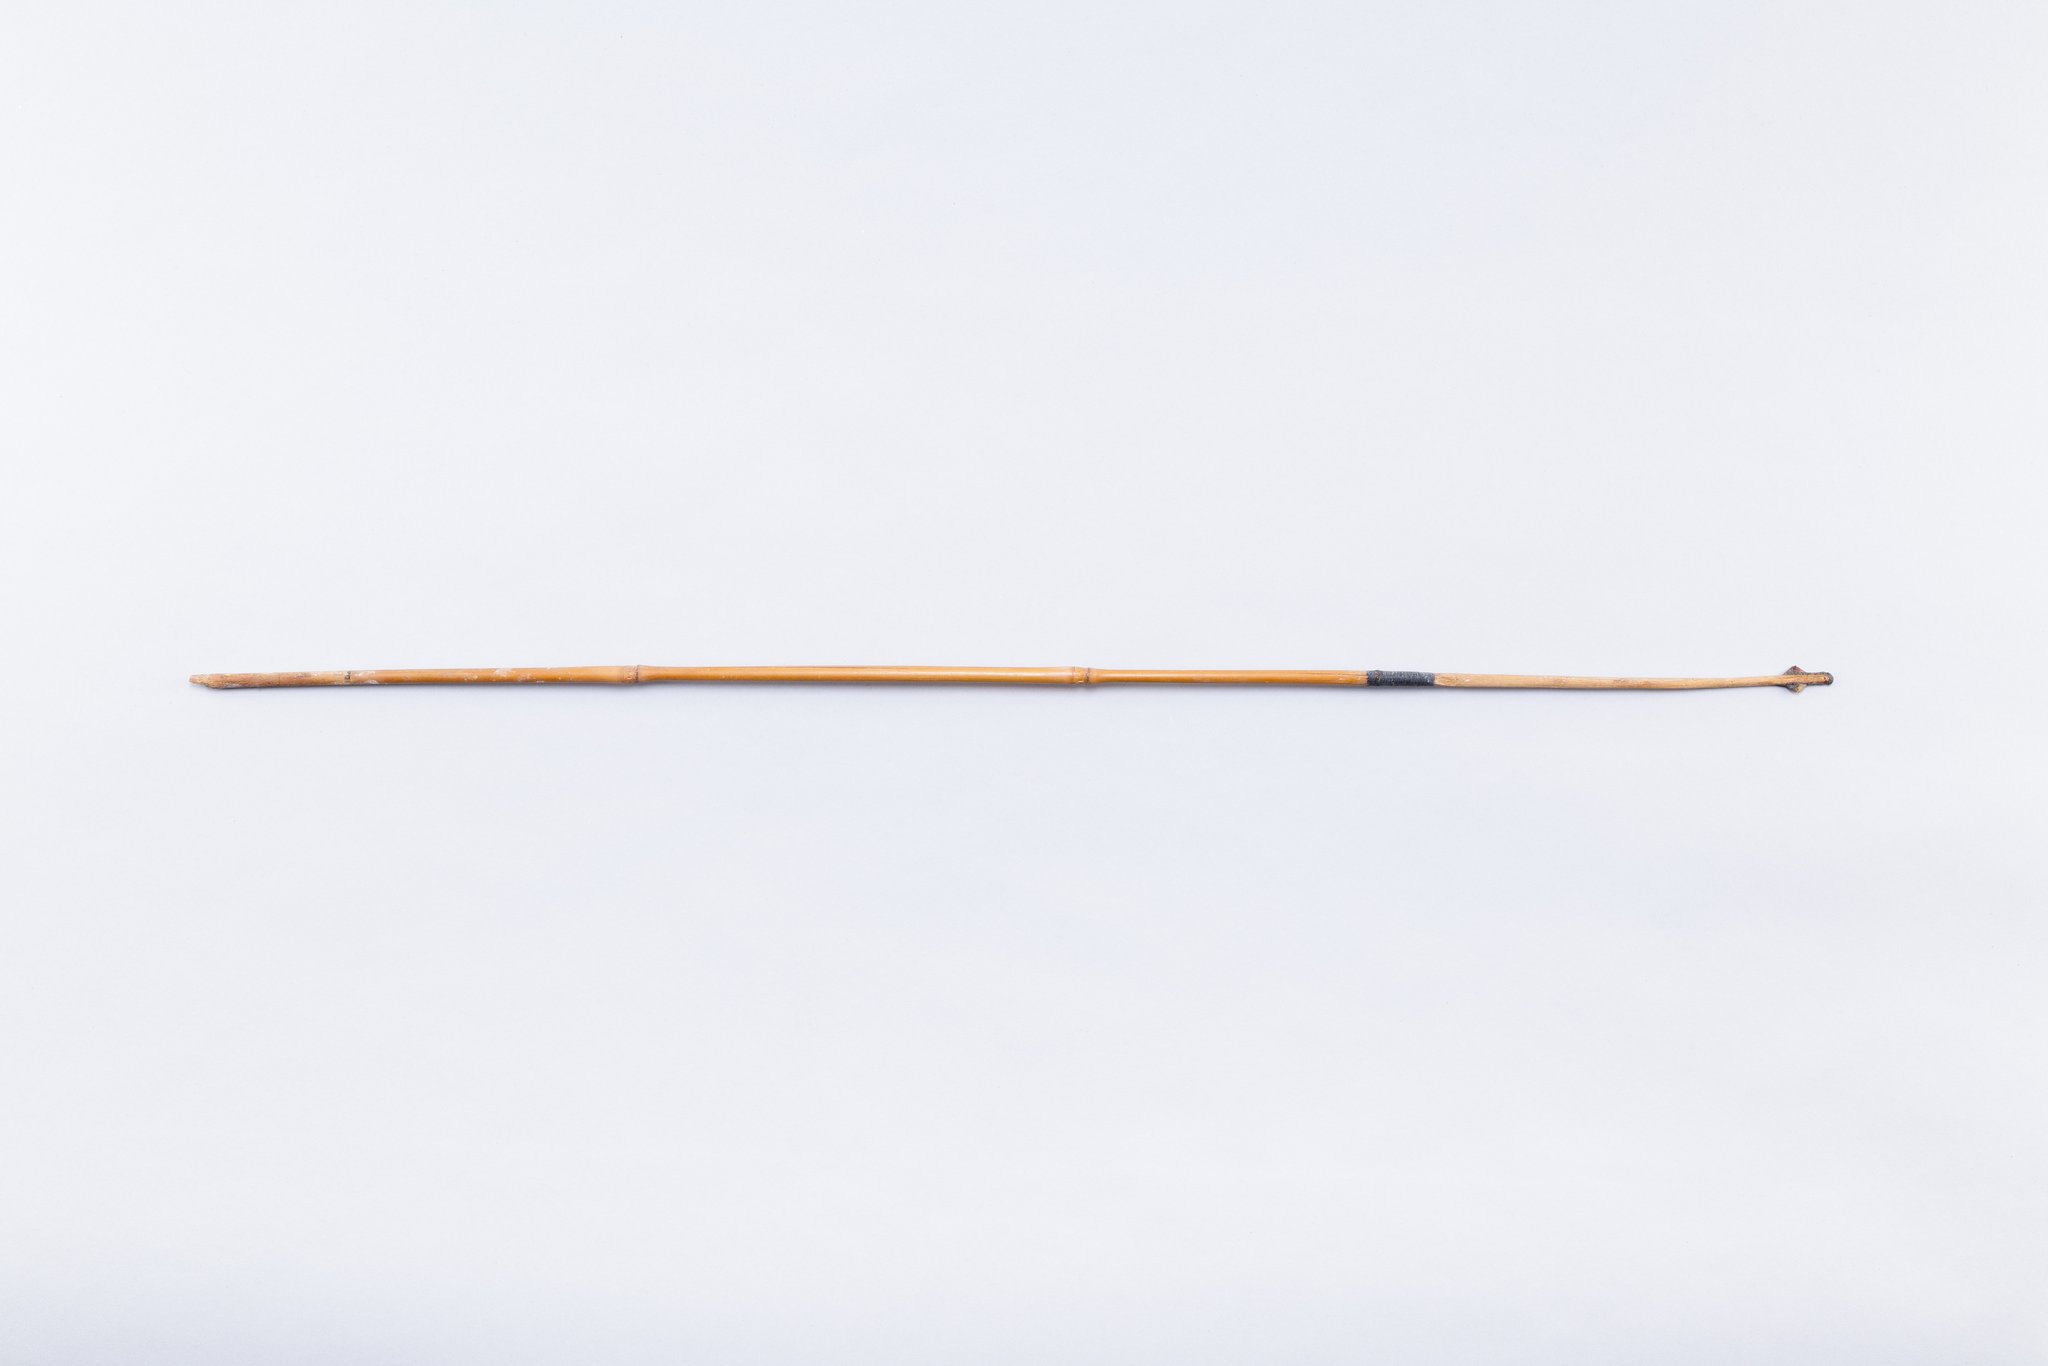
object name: arrow, arrowhead, adhesive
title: Arrow with composite stone tip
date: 1479-1458 BCE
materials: quartz, wood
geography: egypt